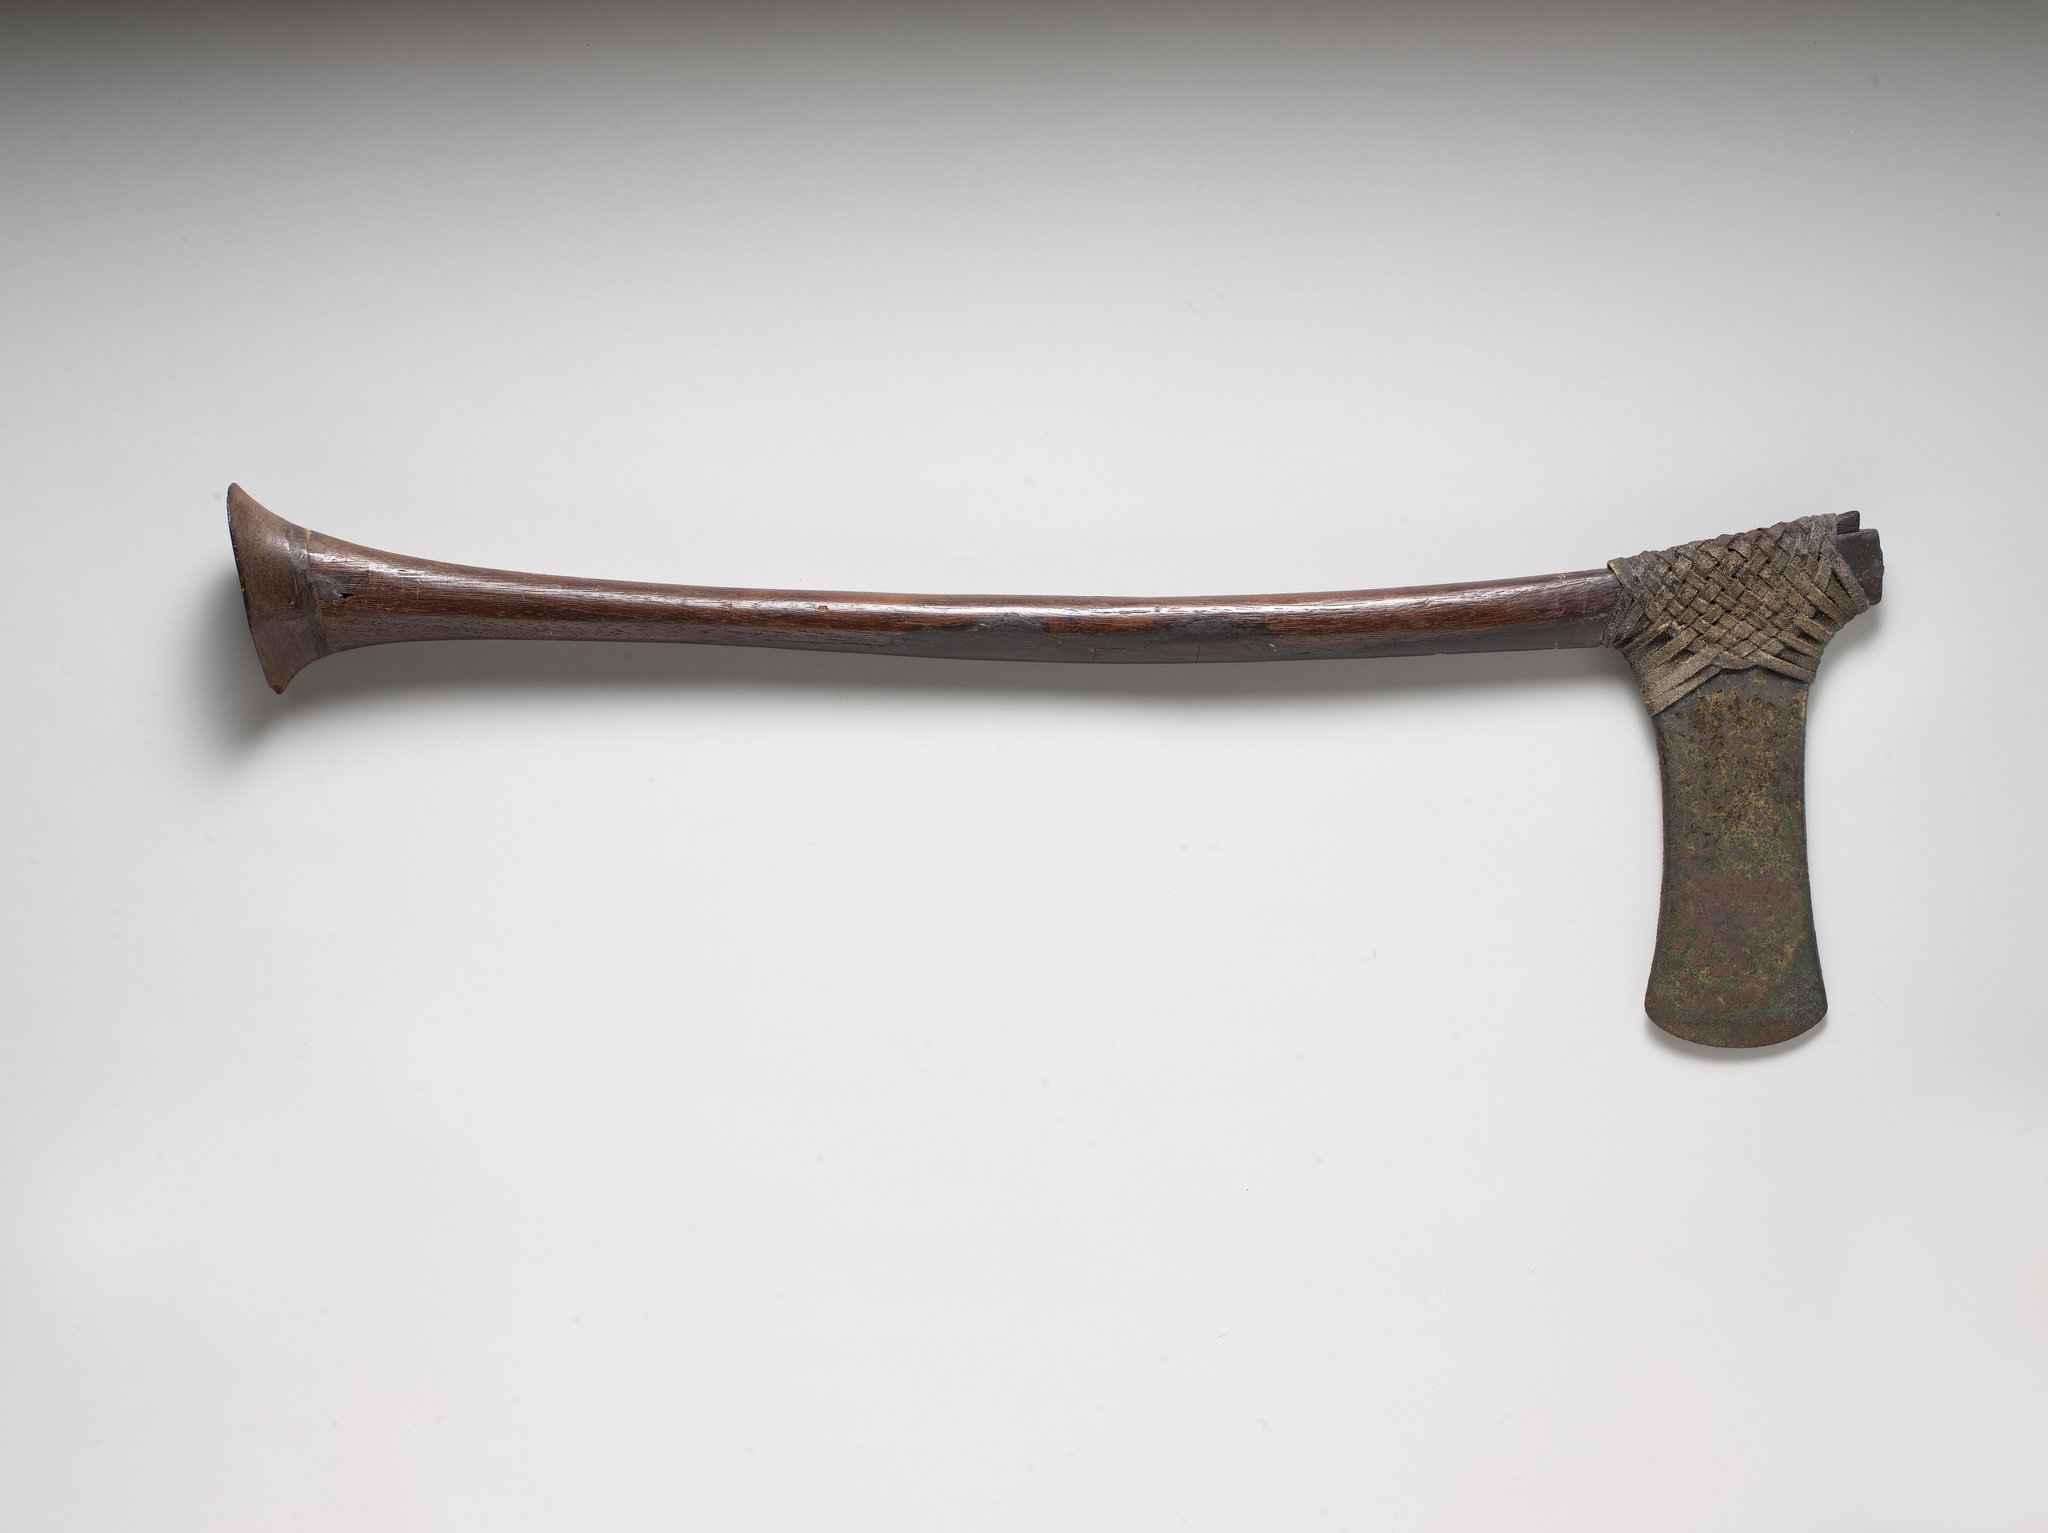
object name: ax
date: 1635-1458 BCE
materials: copper alloy, leather, wood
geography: egypt